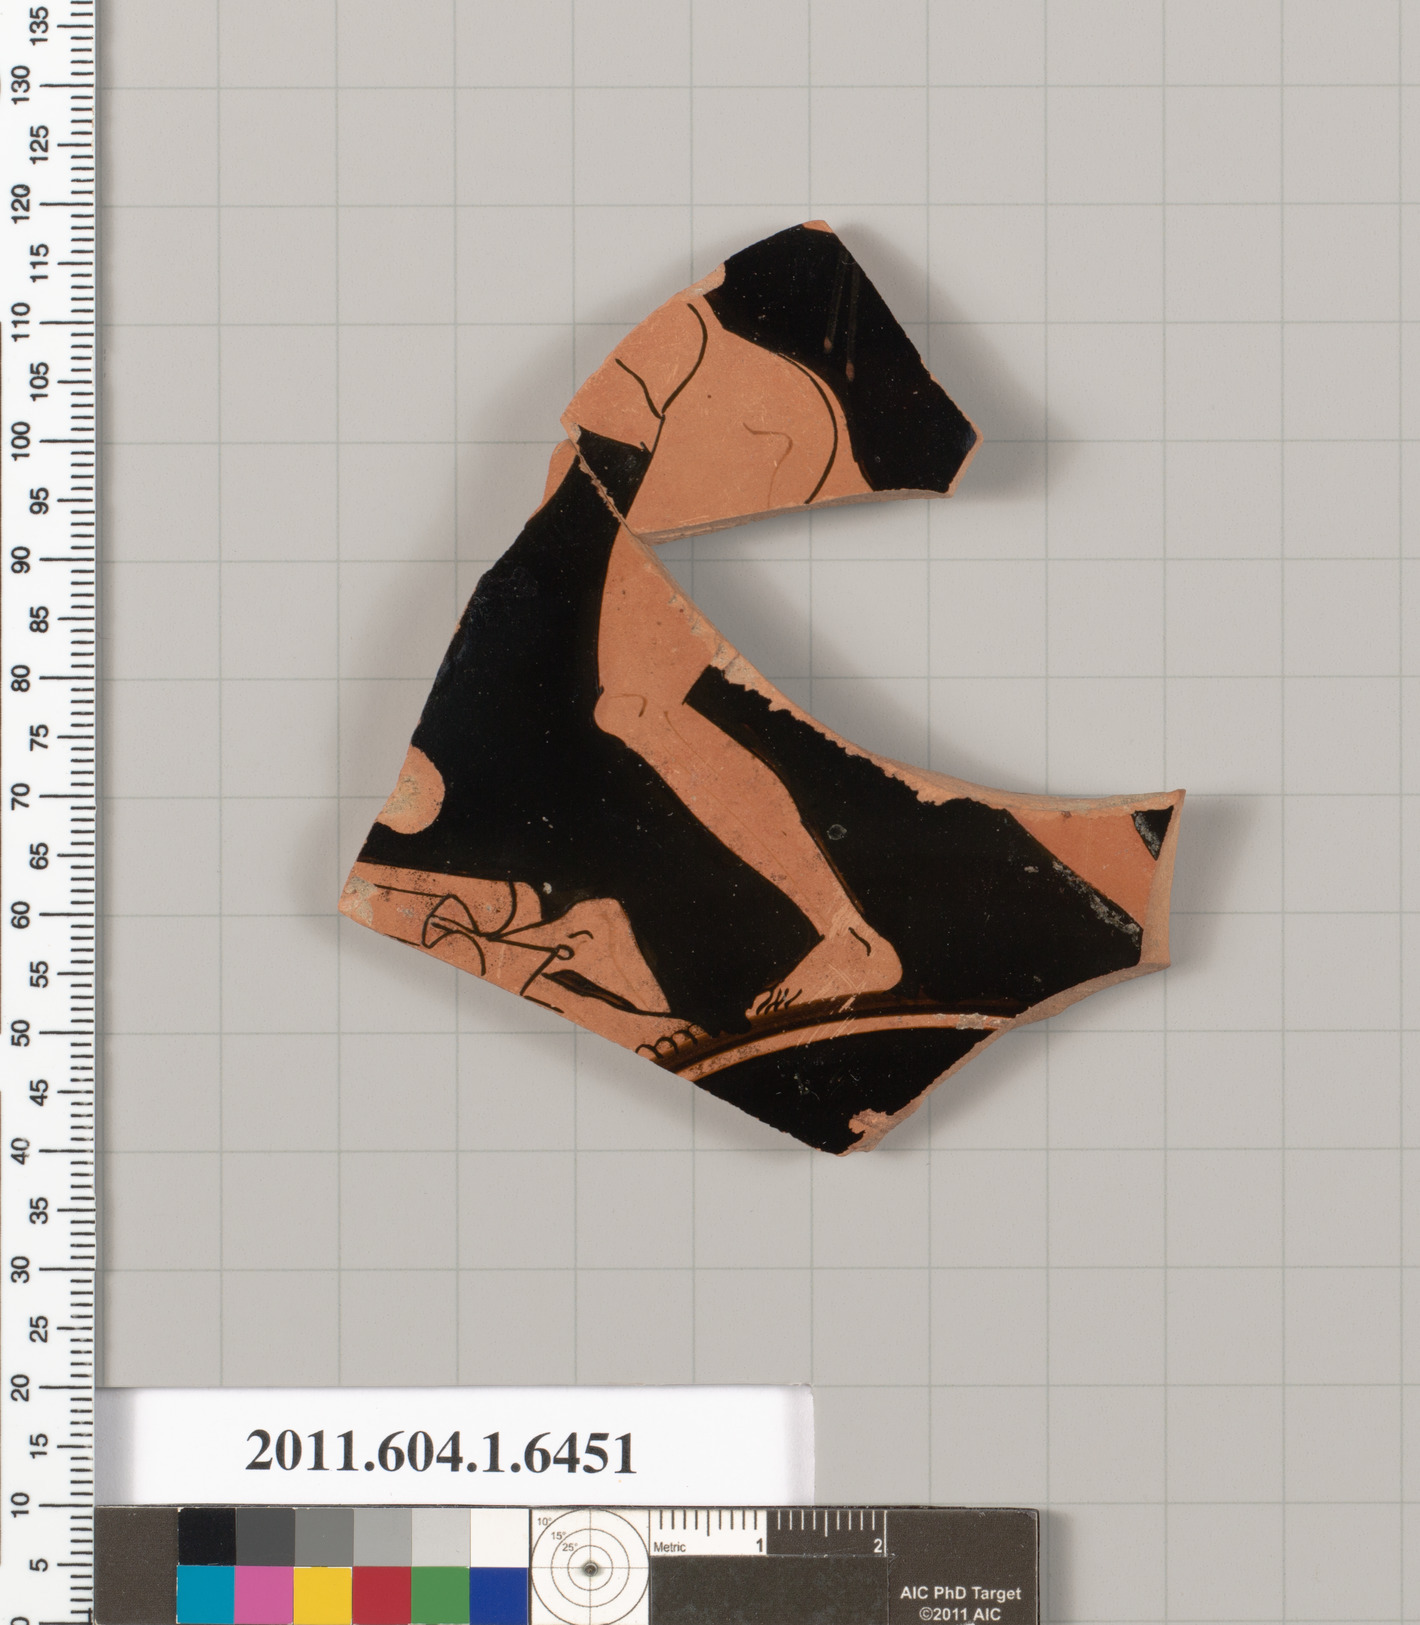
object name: kylix fragment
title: Terracotta fragment of a kylix (drinking cup)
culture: greek, attic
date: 490-480 BCE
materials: terracotta